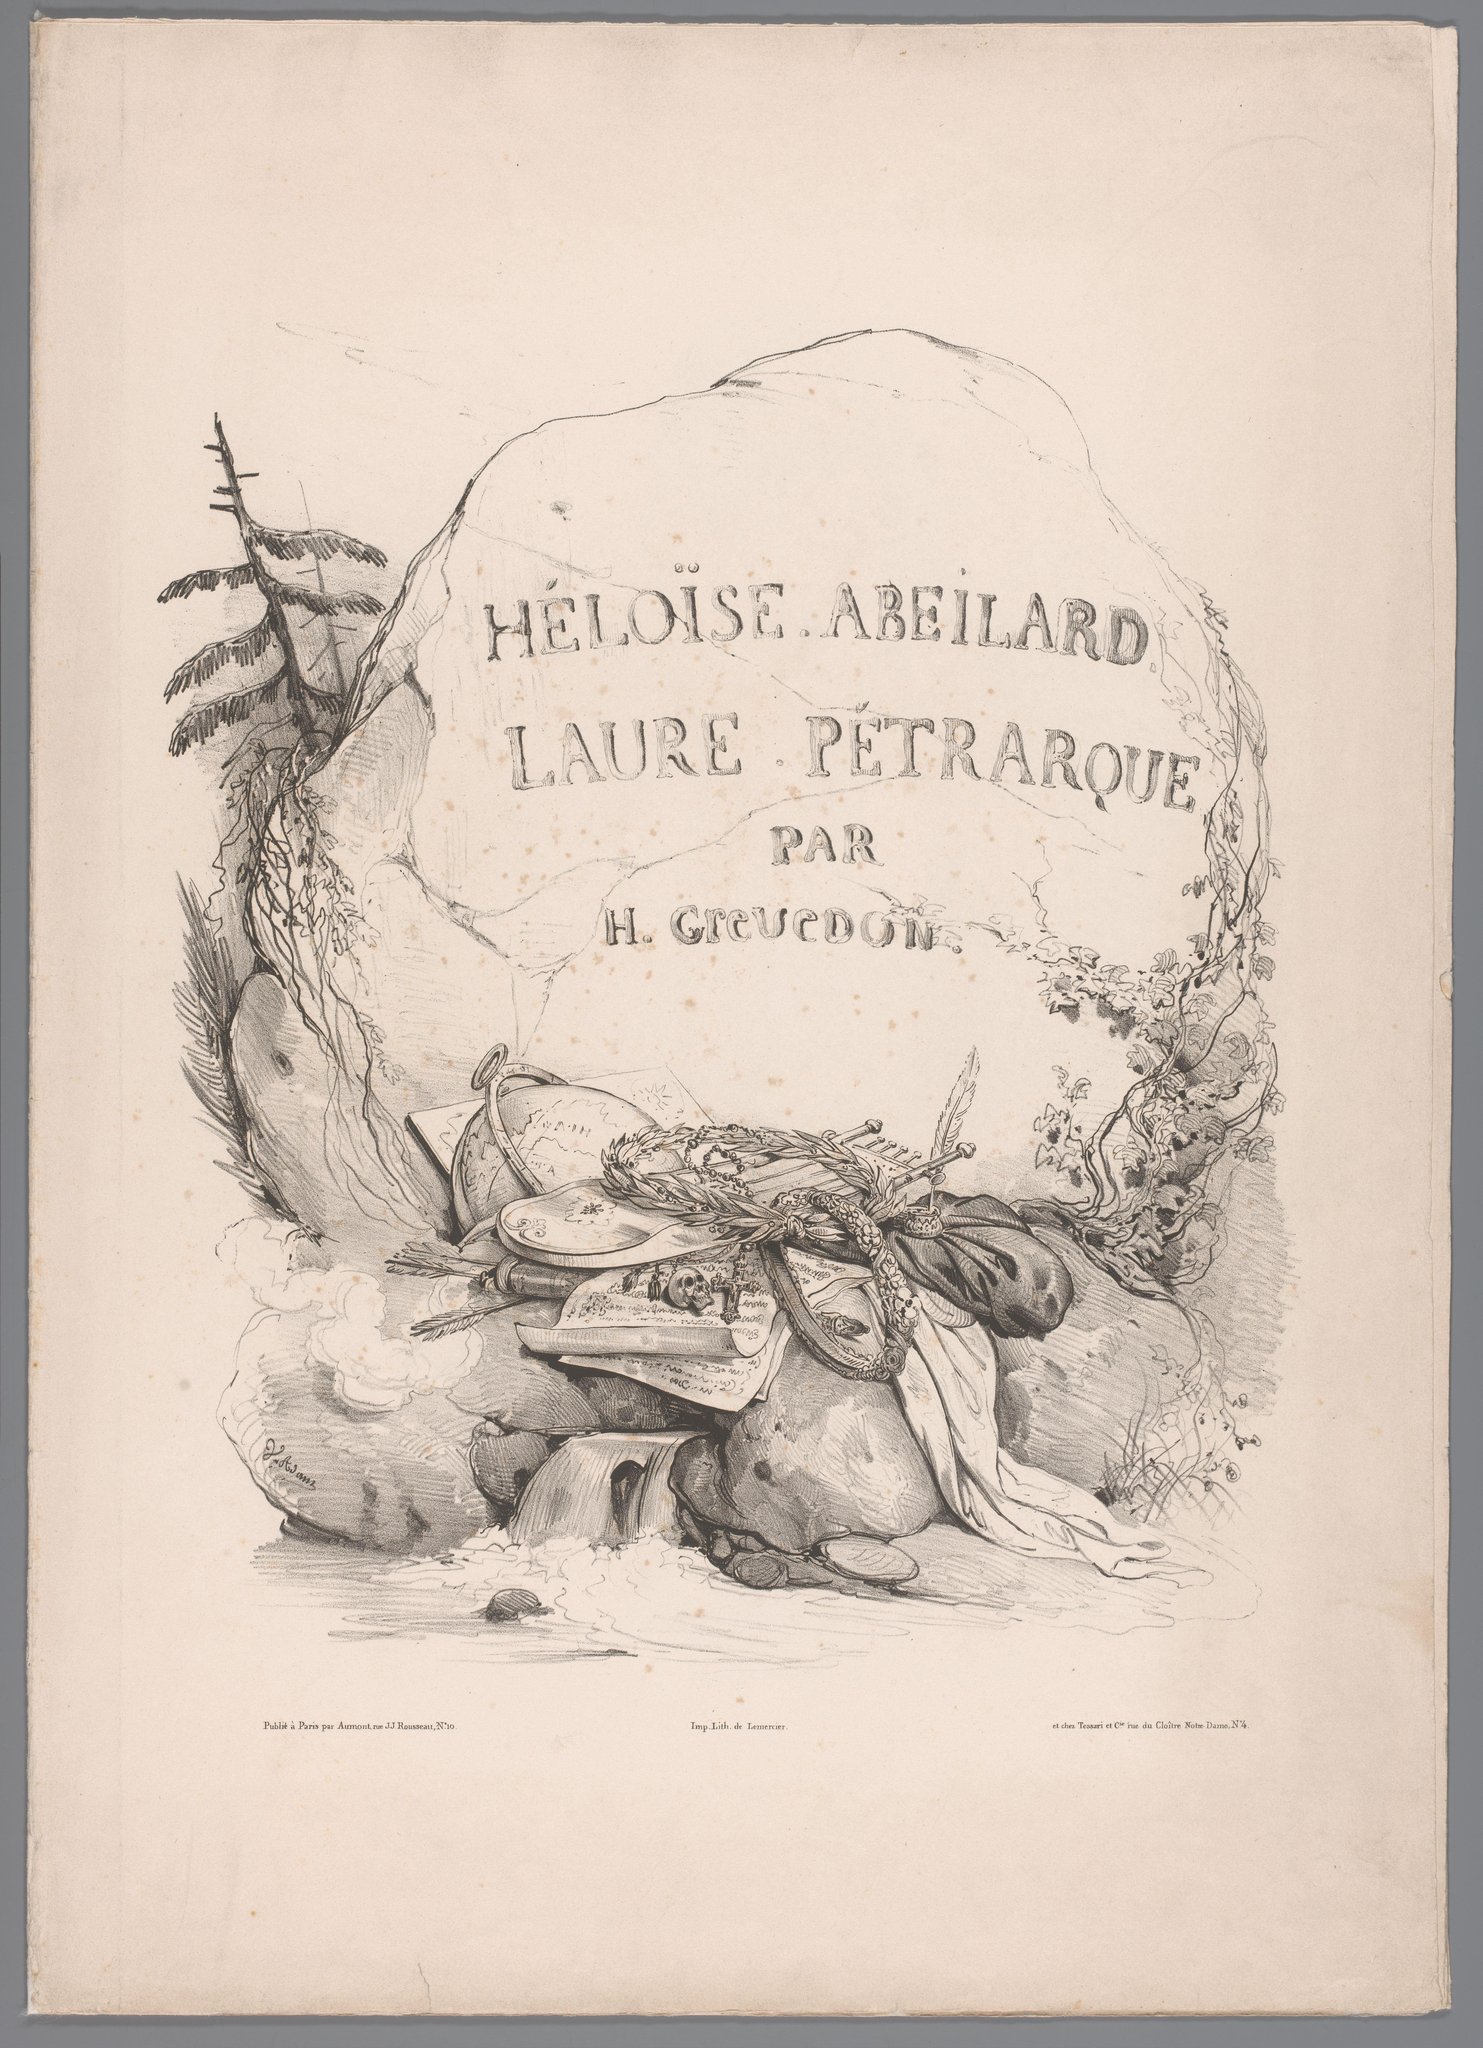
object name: print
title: Beroemde liefdesparen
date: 1834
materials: paper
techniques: lithograph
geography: paris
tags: couple of lovers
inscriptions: collector's mark: Lugt 2228a